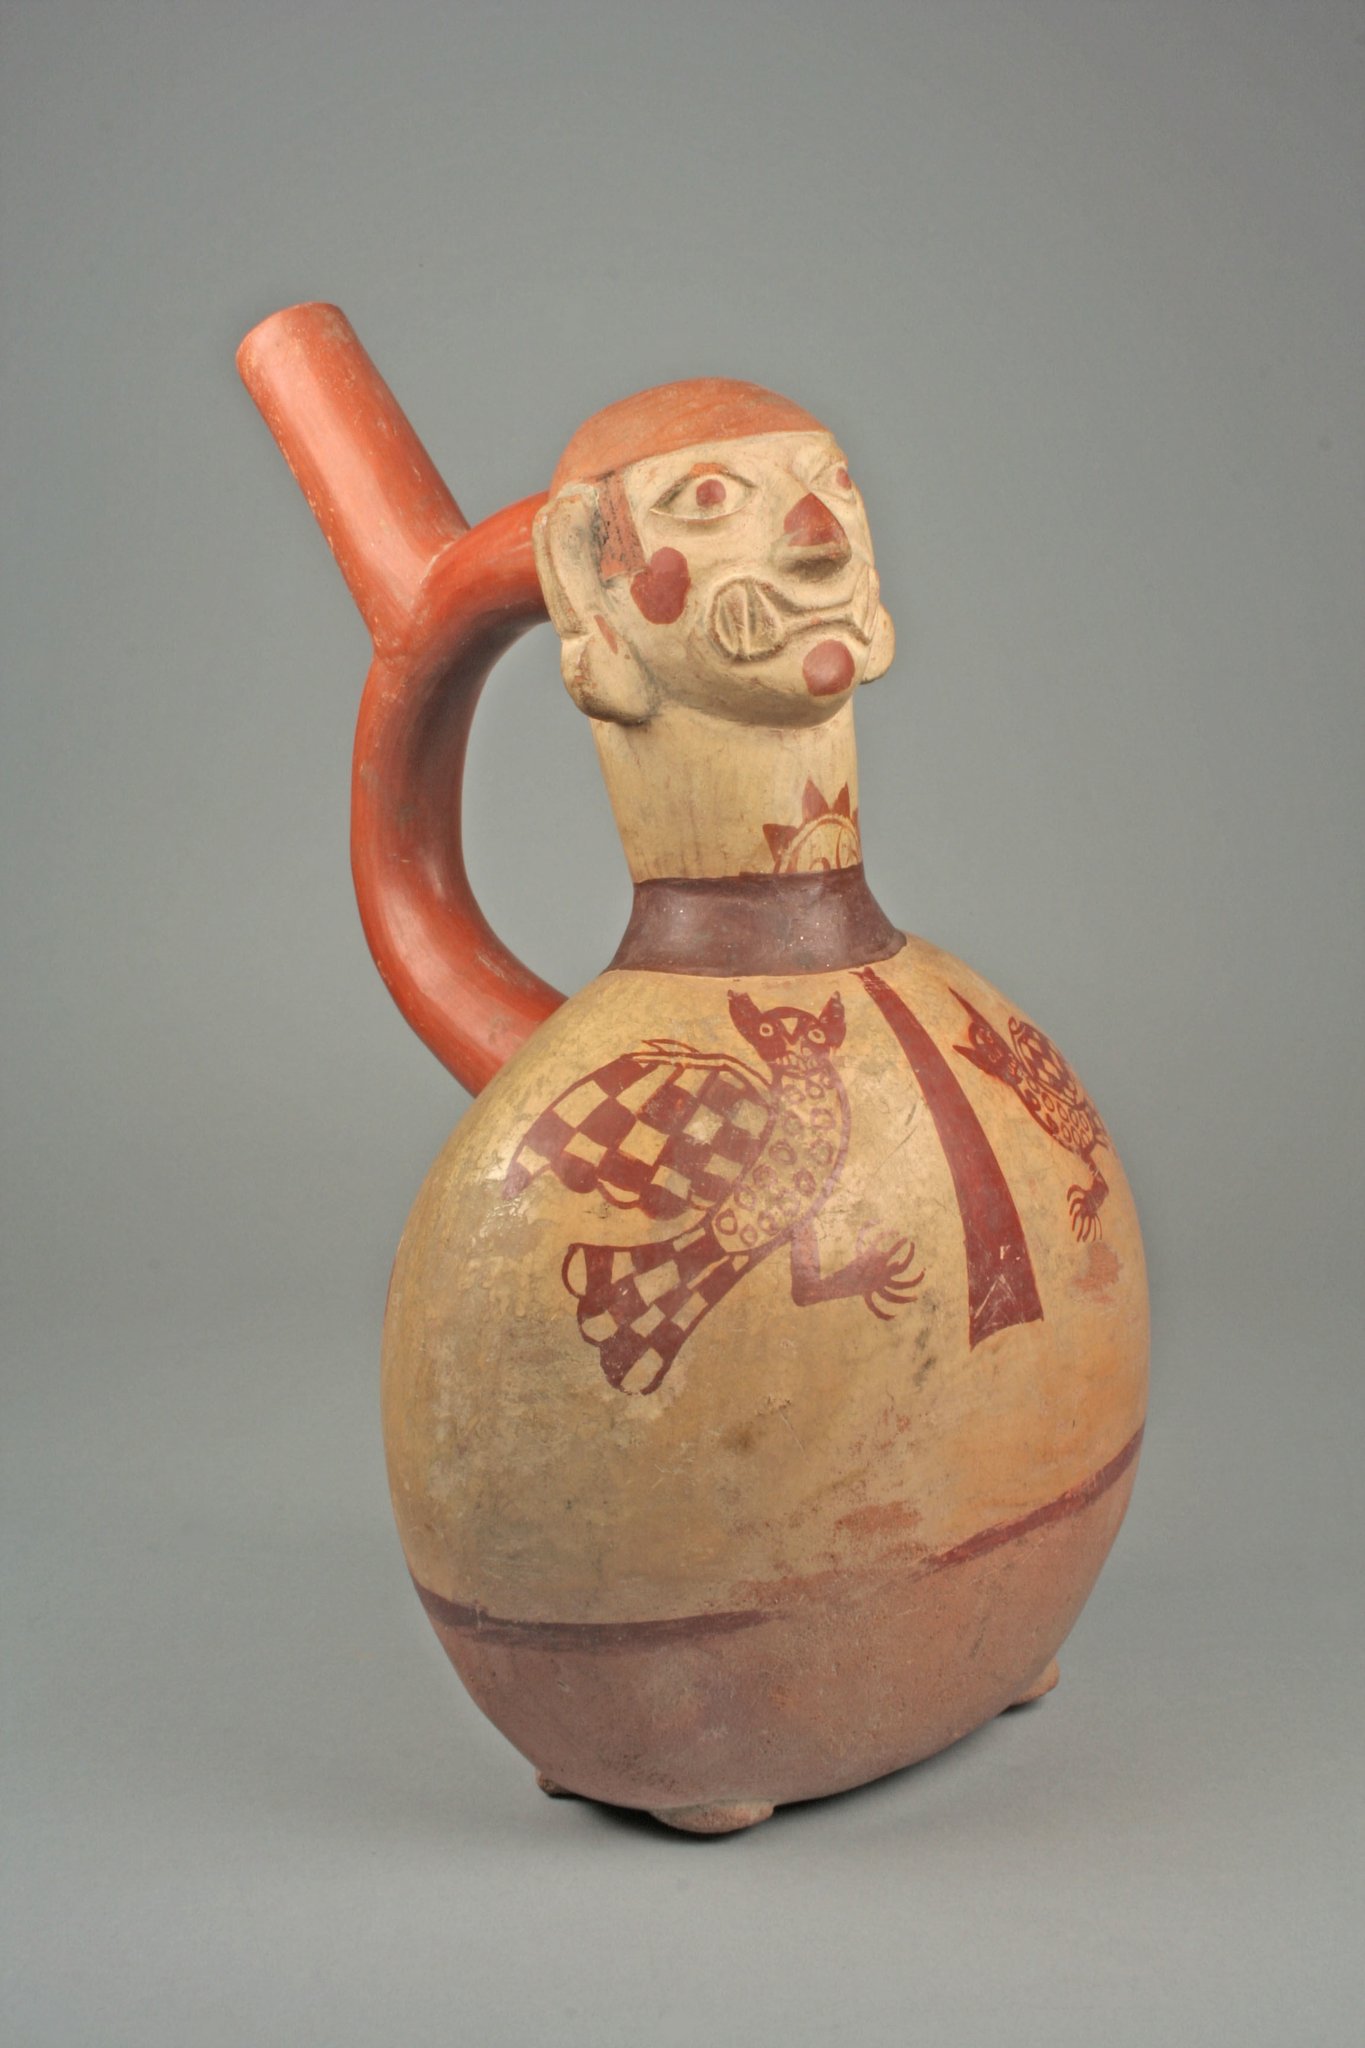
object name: bottle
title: Stirrup Spout Bottle with Ai-Apec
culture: moche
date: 301-700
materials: ceramic, pigment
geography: peru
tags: human figures,birds